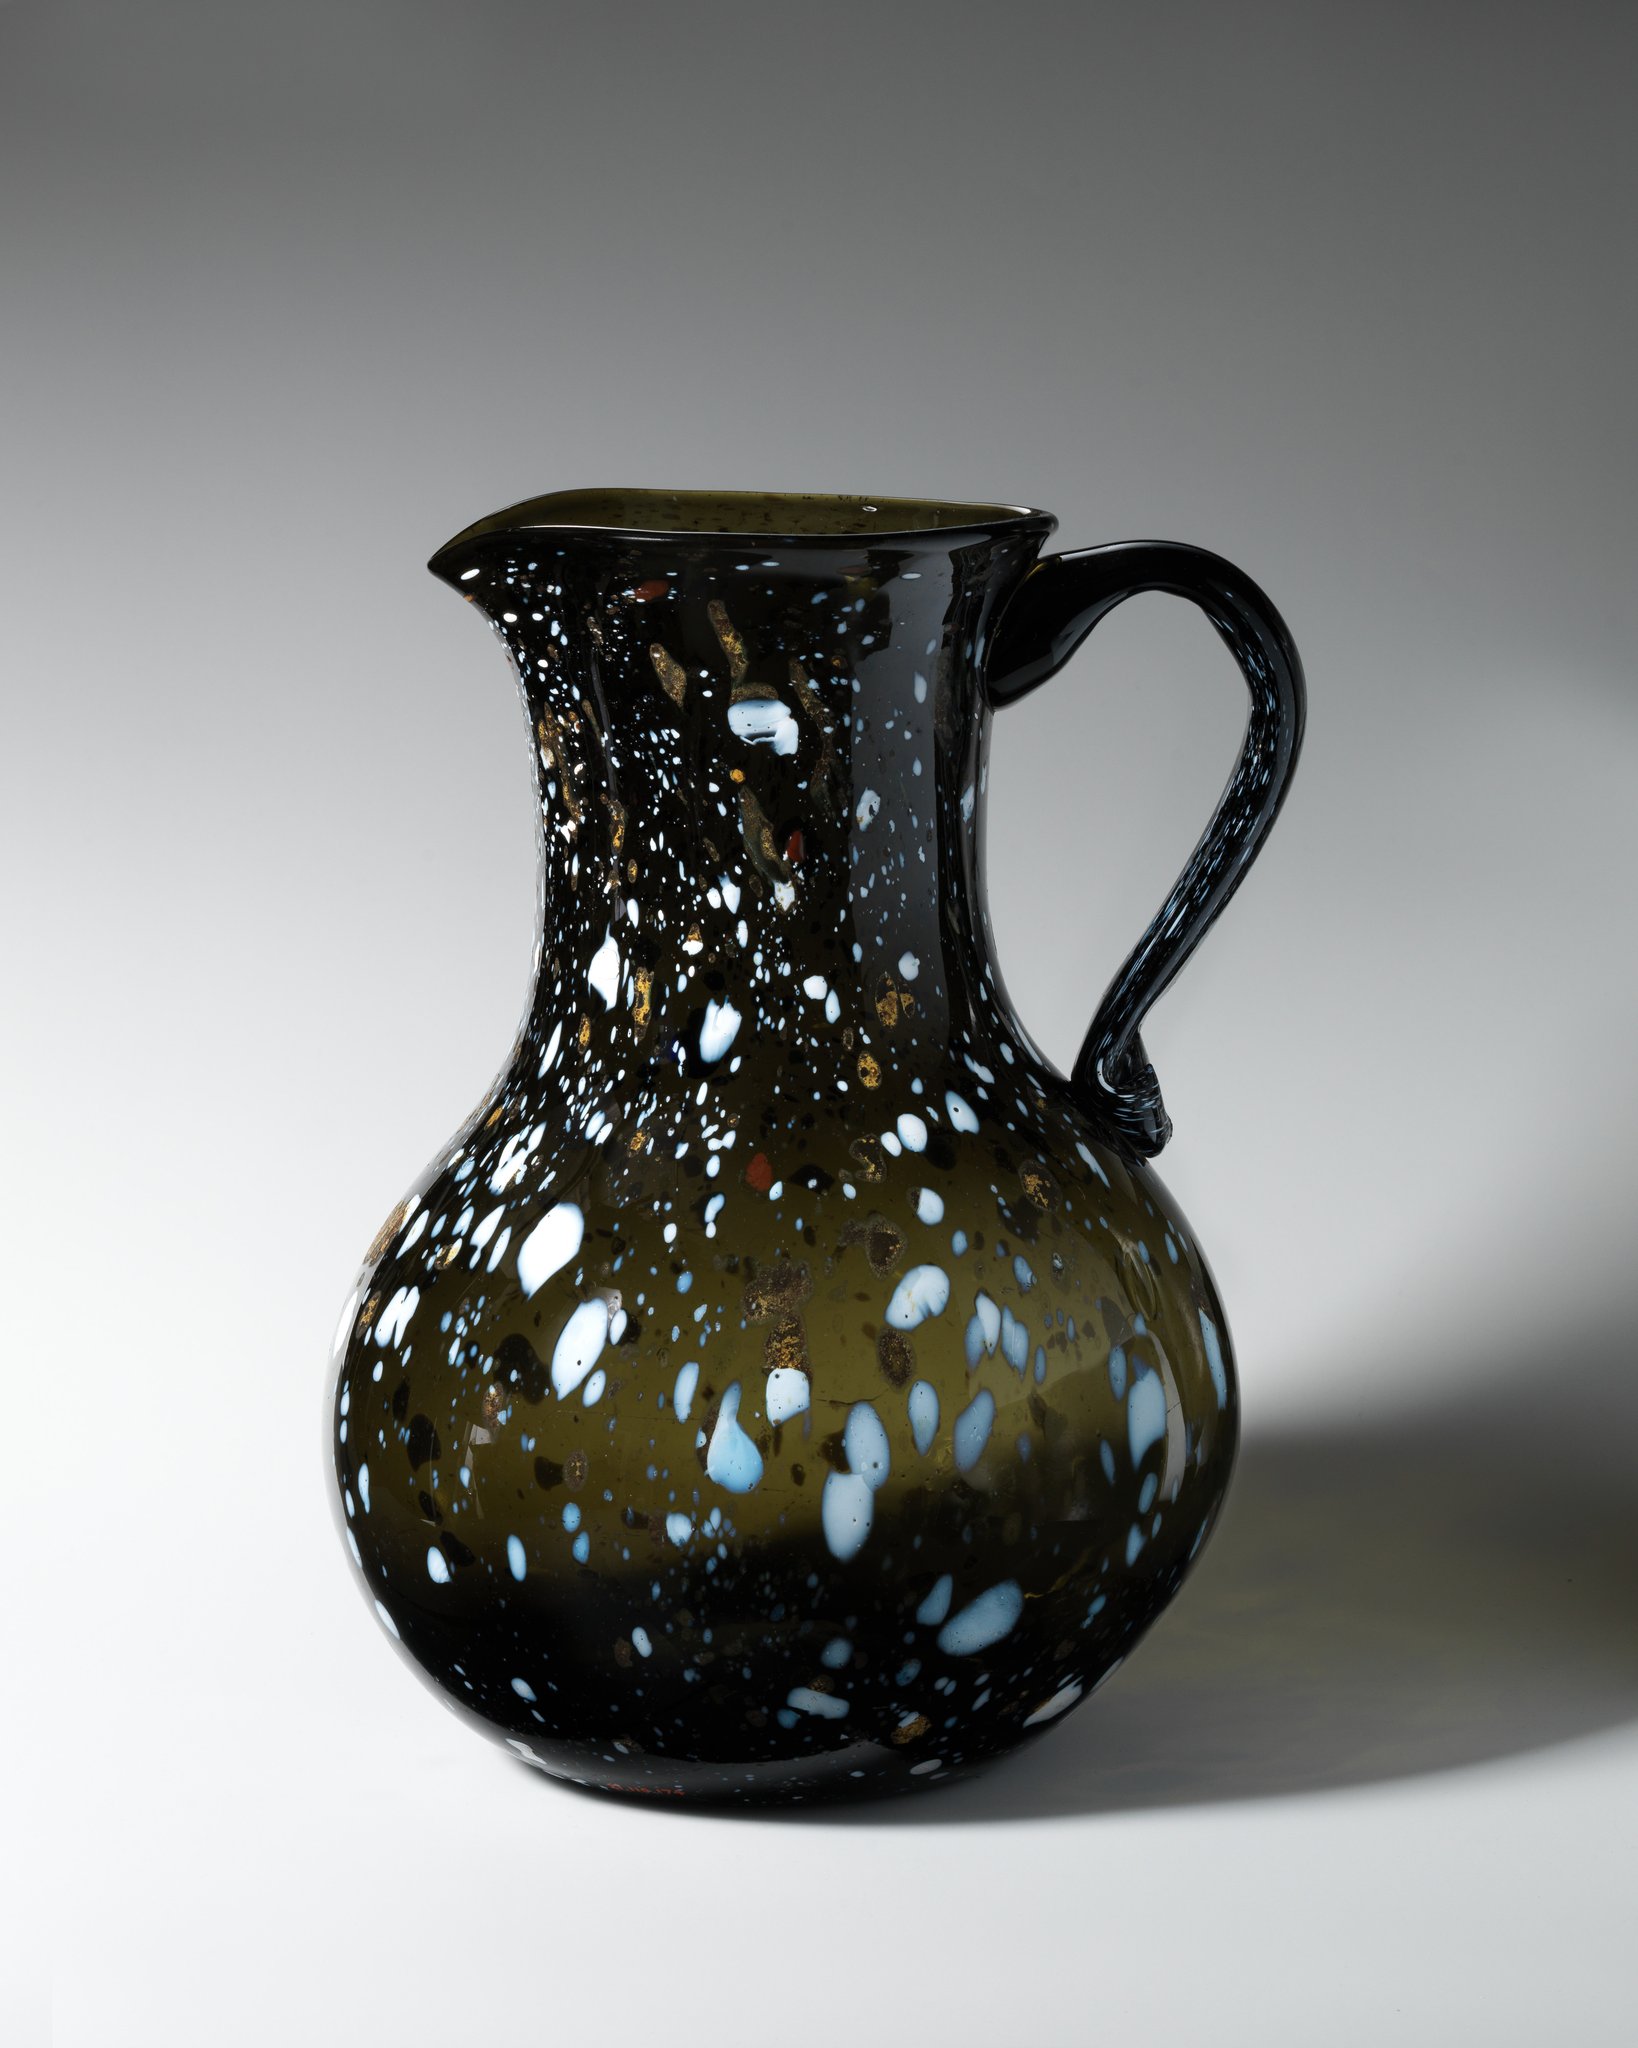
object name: jug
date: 1800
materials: glass